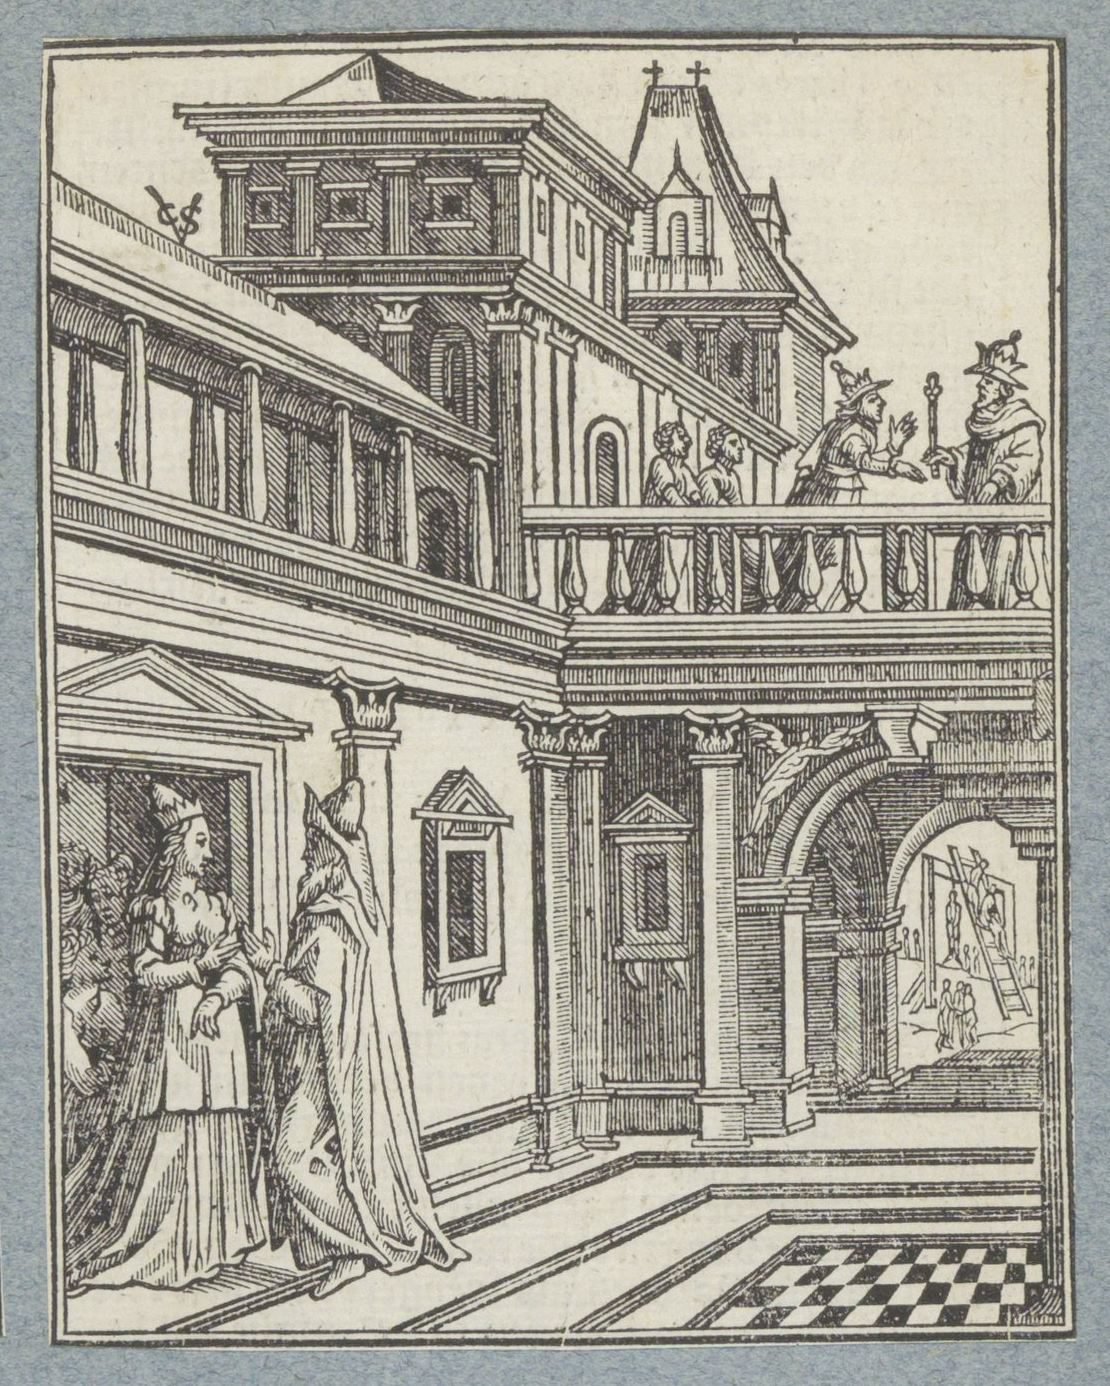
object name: album leaf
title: Ester voor het huis van Haman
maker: pieter jacobsz. paets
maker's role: publisher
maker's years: 1587-1667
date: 1645-1657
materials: paper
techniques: letterpress printing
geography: amsterdam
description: Wanneer Mordekai erachter komt dat twee lijfwachten van de koning een aanslag plannen vertelt hij aan koningin Ester (bij de deur) wat hij heeft gehoord. Op de achtergrond op een galerij waarschuwt Ester Ahasveros voor de lijfwachten. Zij werden ter dood veroordeeld. De prent maakt deel uit van een album.